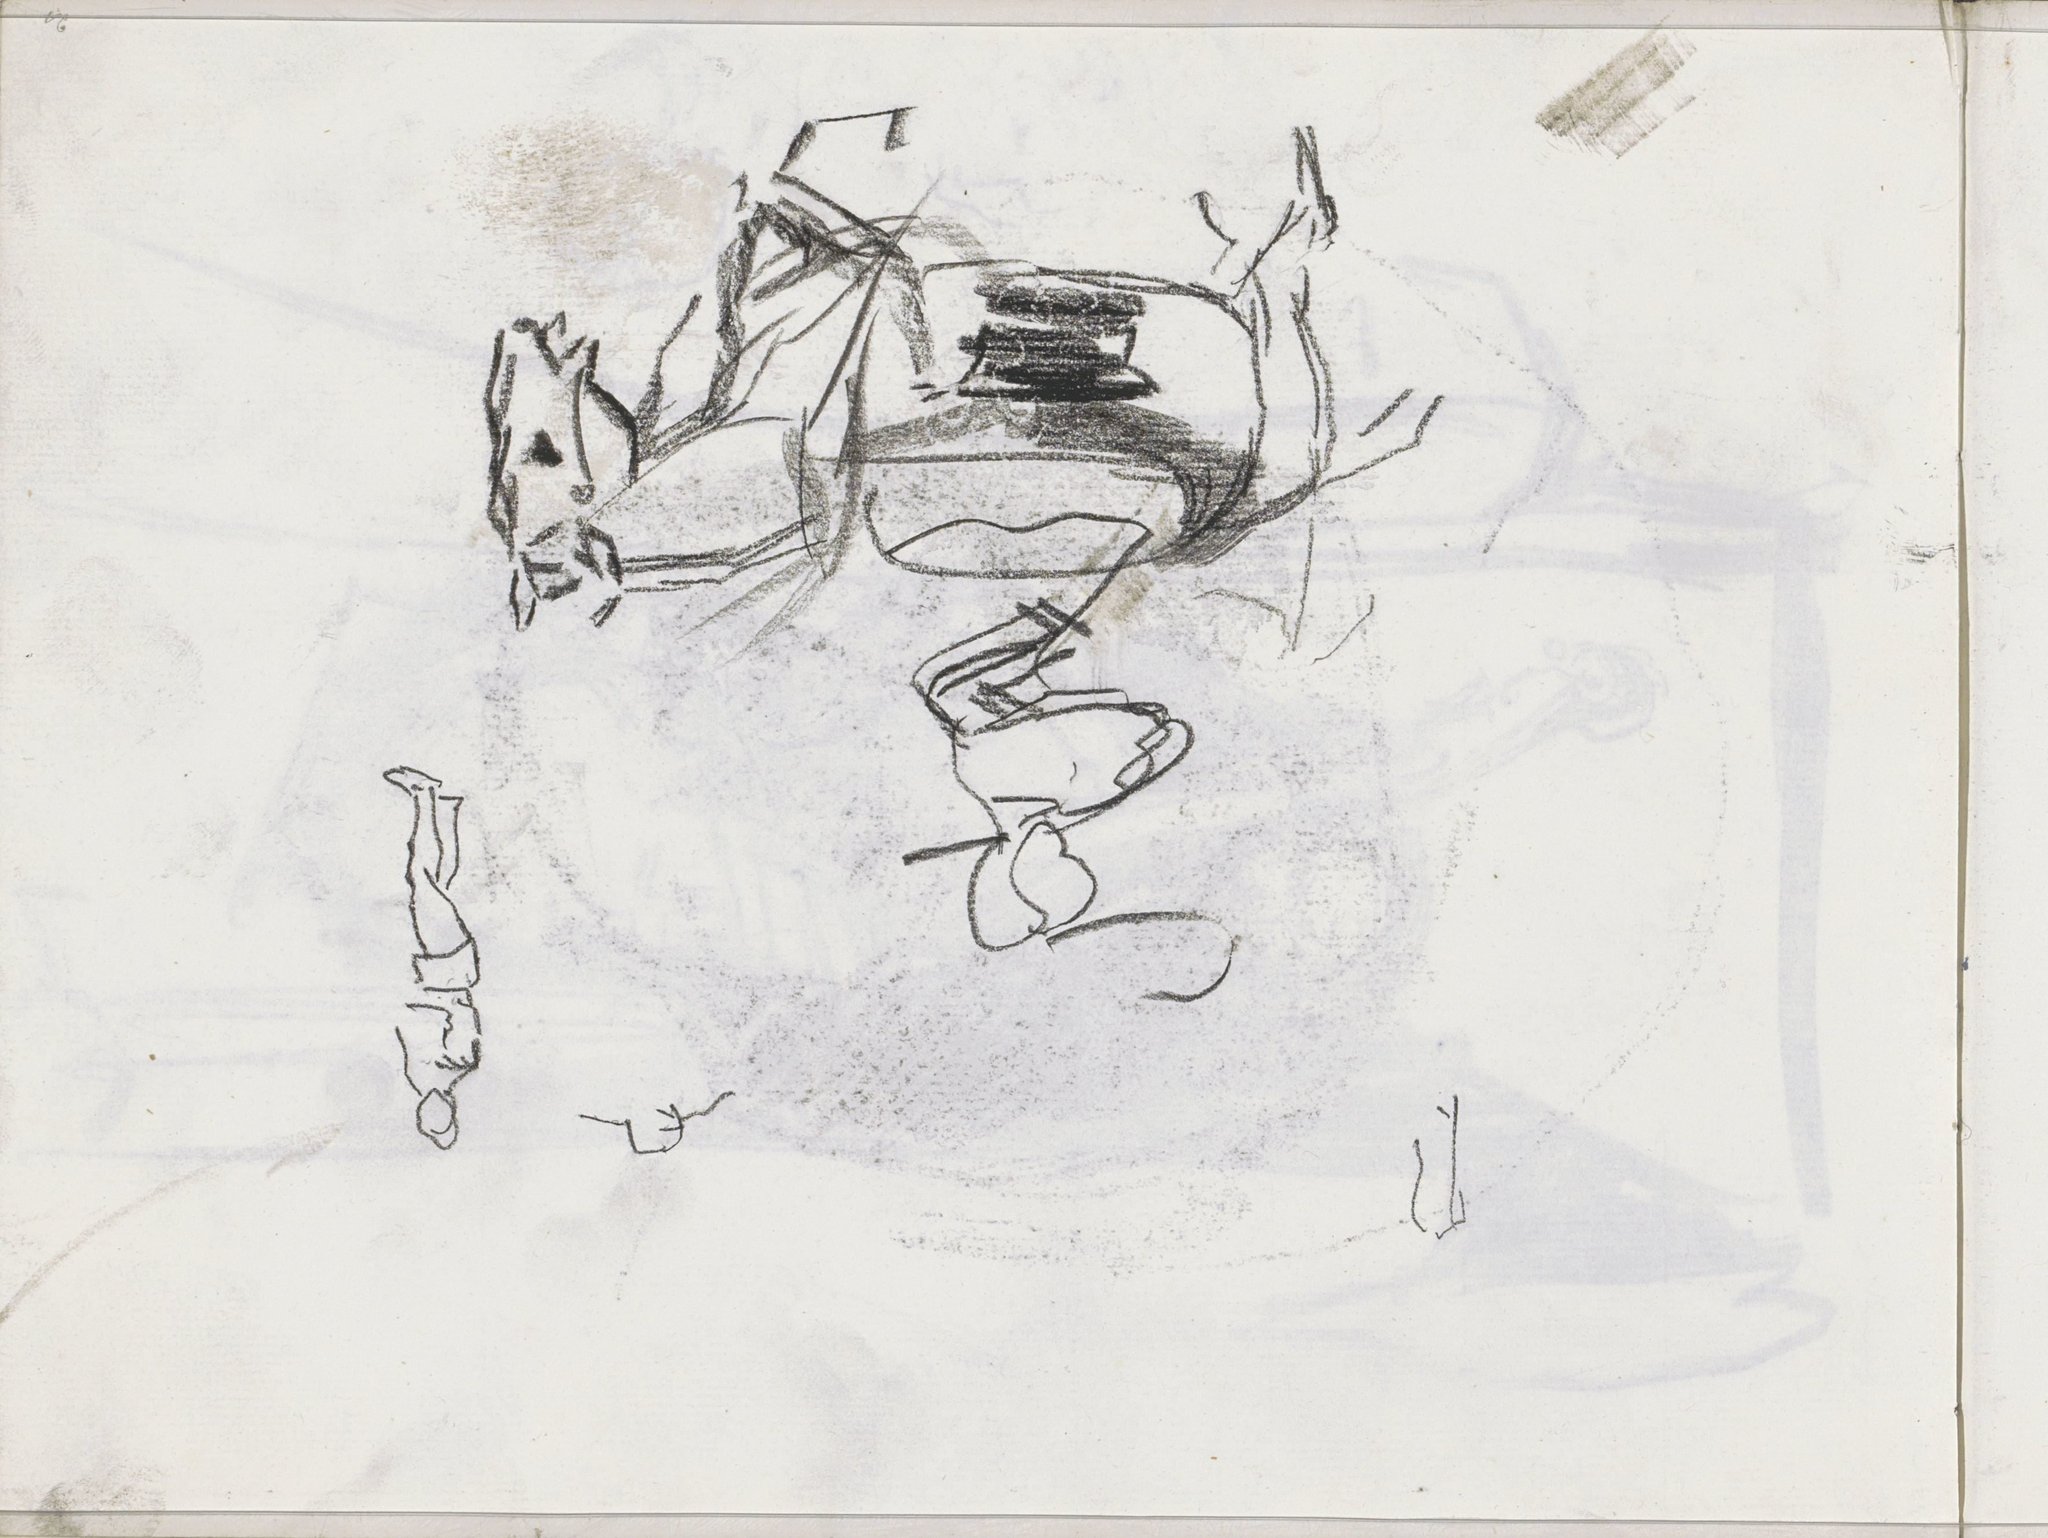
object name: sketchbook leaf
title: Figuur op een ezel of paard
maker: isaac israels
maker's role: draughtsman, painter, print maker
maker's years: 1865-1934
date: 1875-1934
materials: chalk, paper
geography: the hague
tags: riding a horse, ass, or mule; rider, horseman, donkey-riding (on the beach)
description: Blad 14 verso uit schetsboek XIV met 17 bladen.